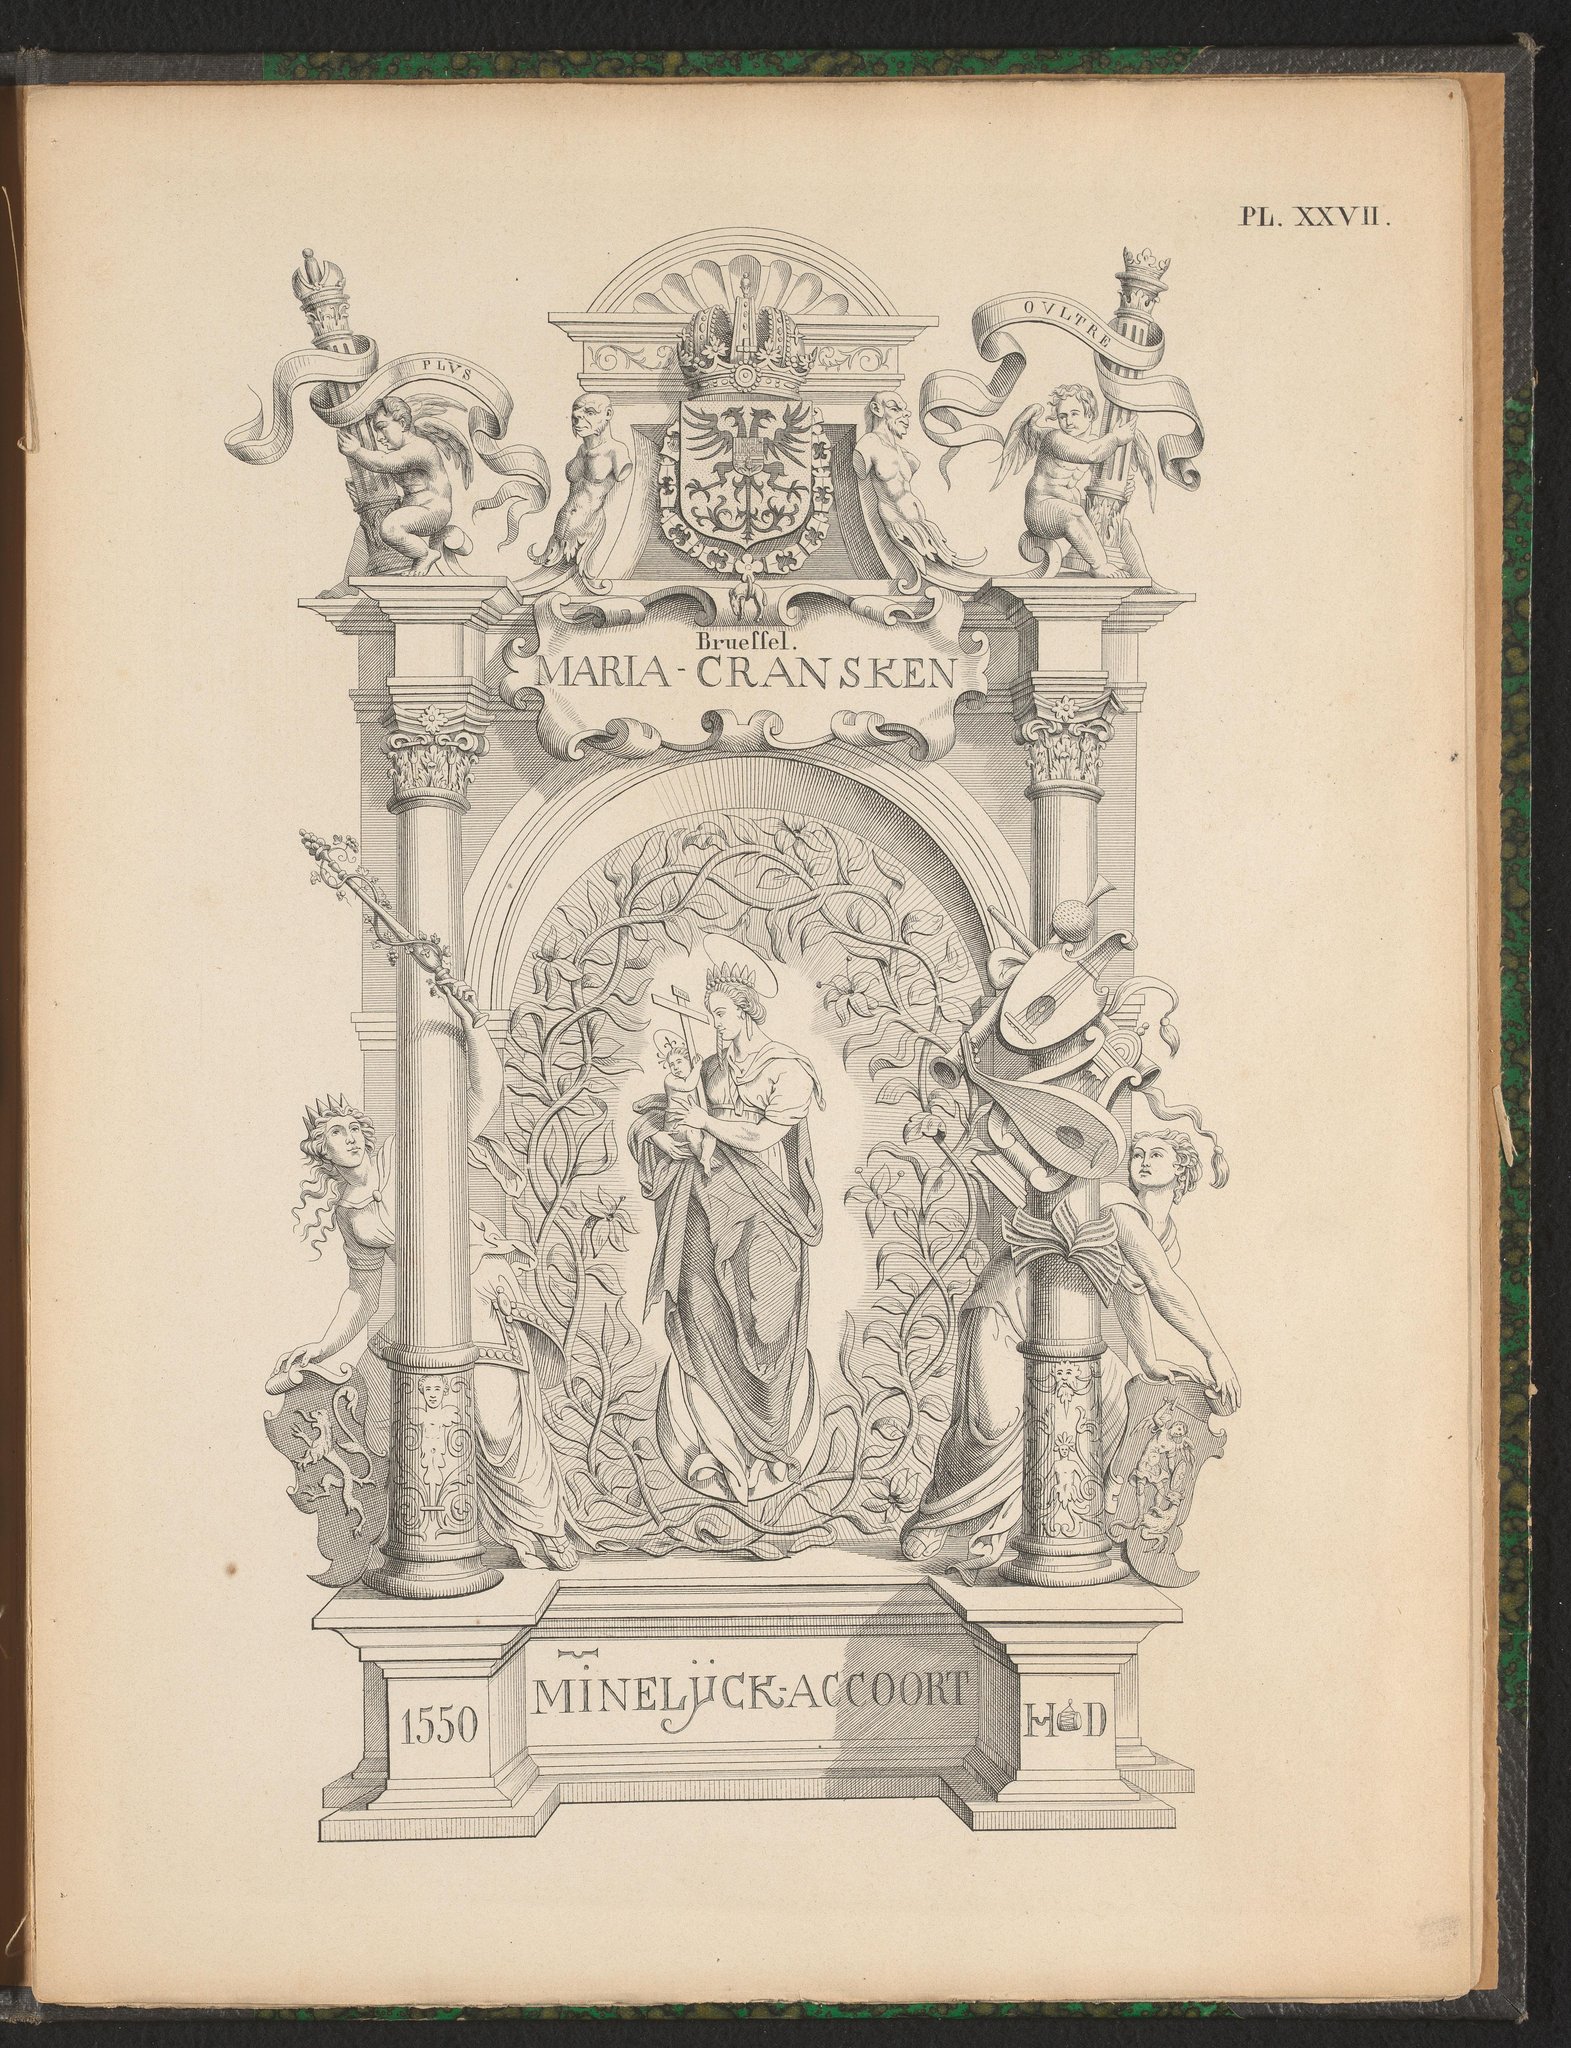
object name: print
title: Blazoen van Het Mariacransken (Brussel), 1561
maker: l. van peteghem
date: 1859-1861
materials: paper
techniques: lithograph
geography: belgium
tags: chamber of rhetoric (dutch: 'rederijkerskamer'), antwerp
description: Blazoen van Het Mariacransken, rederijkerskamers van Brussel, 1561. Plaat XXVII in een map met 35 genummerde platen, de meeste naar de illustraties in de oorspronkelijke uitgave van het Landjuweel van Antwerpen in 1561.